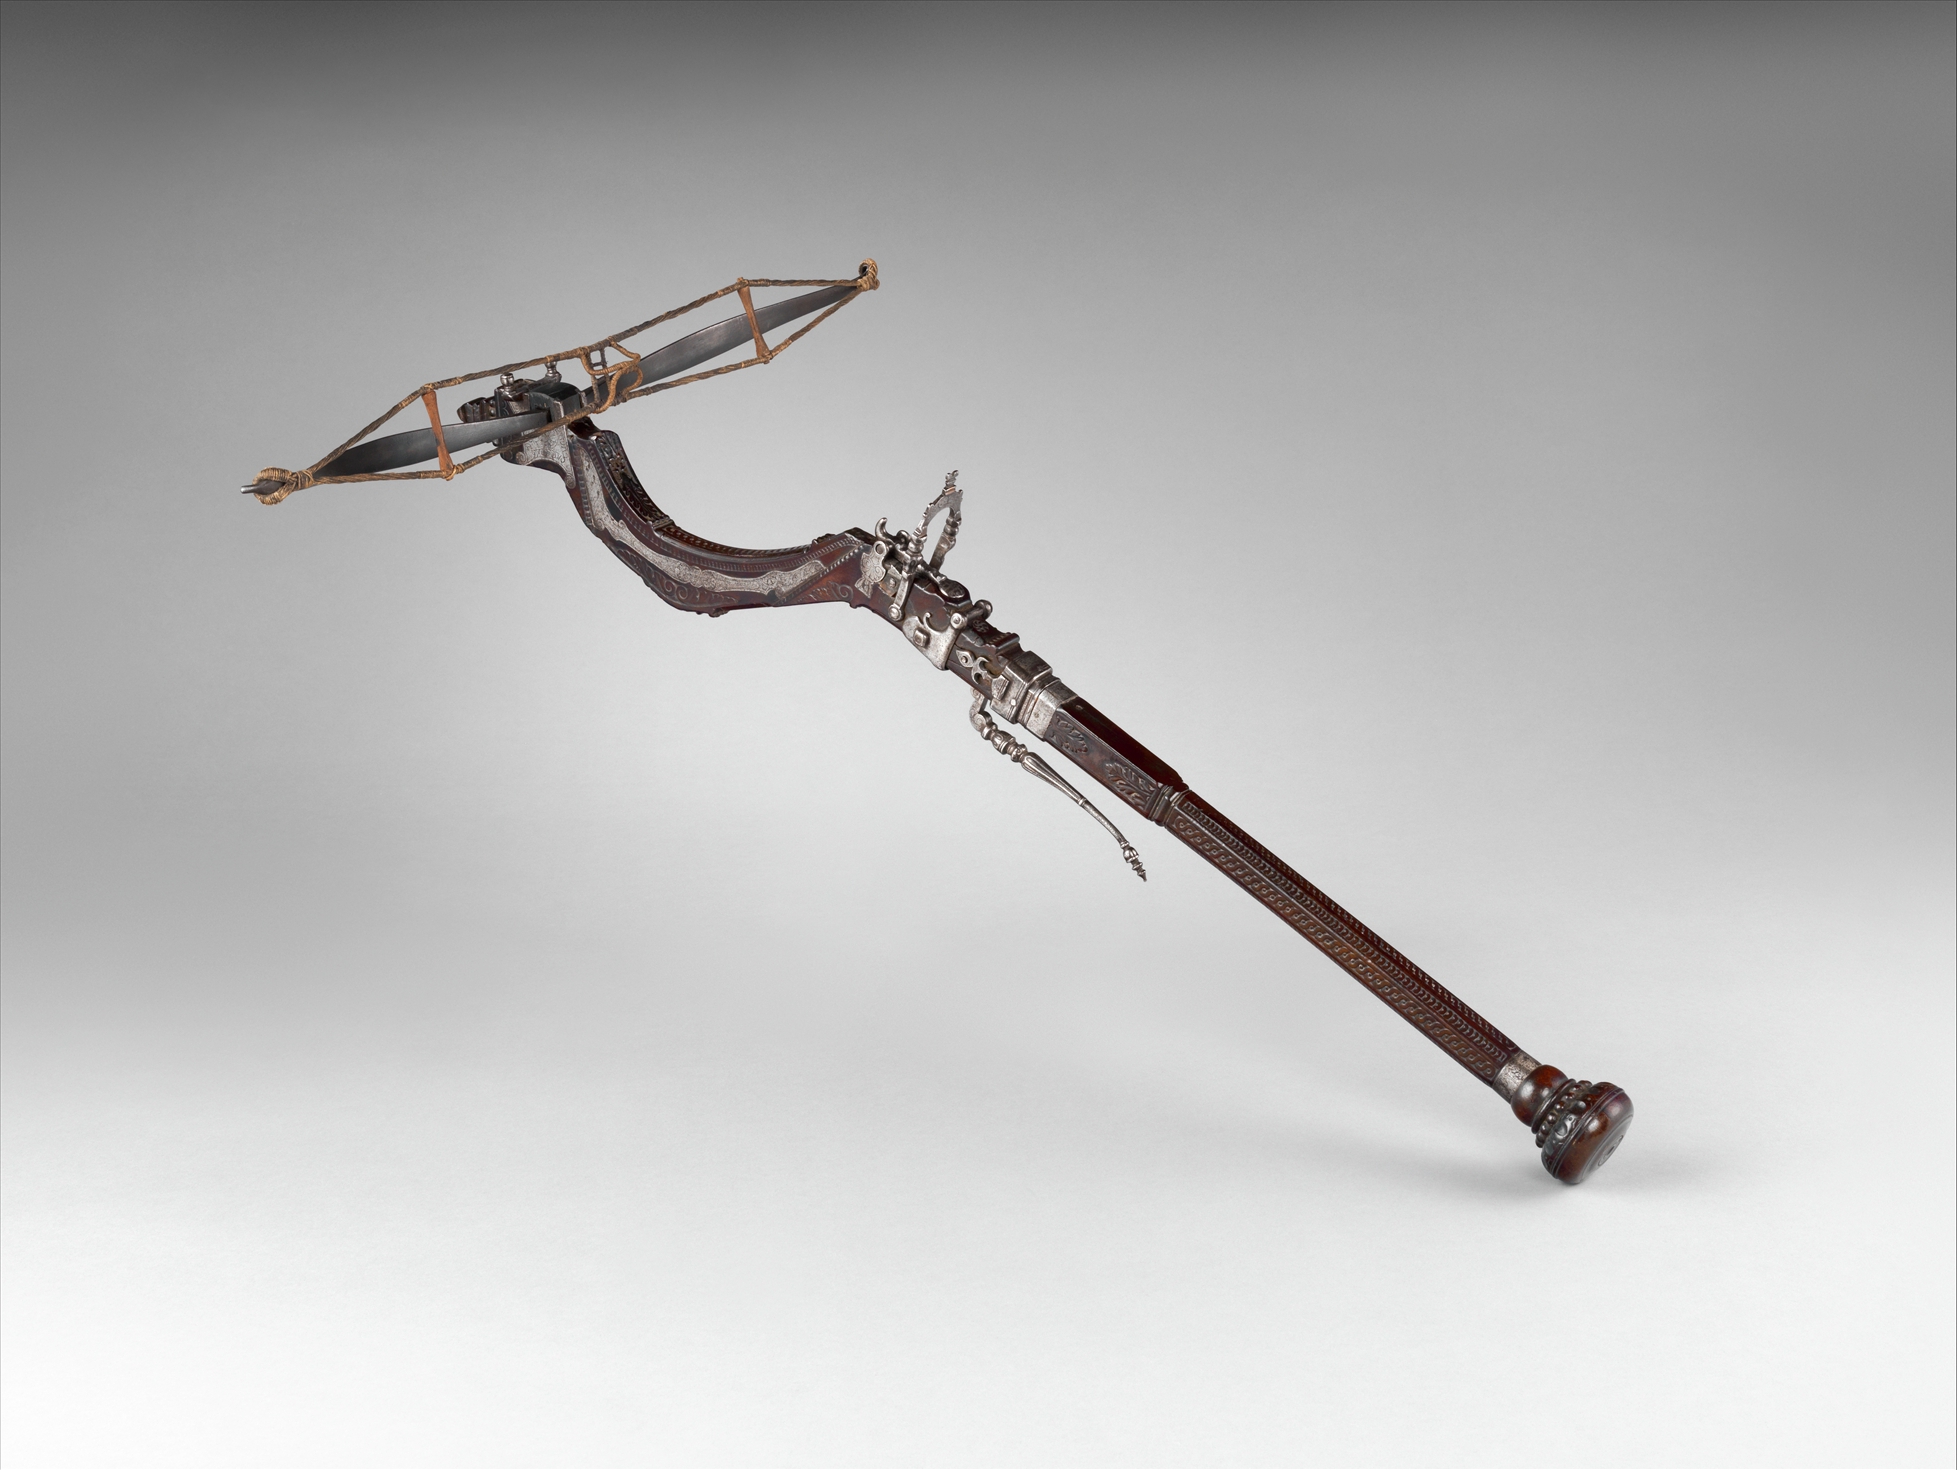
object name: pellet crossbow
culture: german or italian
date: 1550-1600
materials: copper alloy, metal alloy, steel, wood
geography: germany